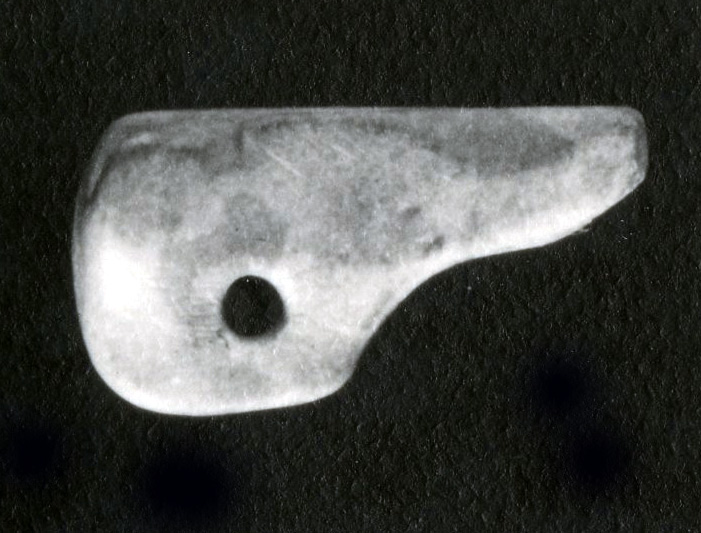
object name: amulet, anubis head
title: Anubis head amulet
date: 2110-2030 BCE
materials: ivory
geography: egypt